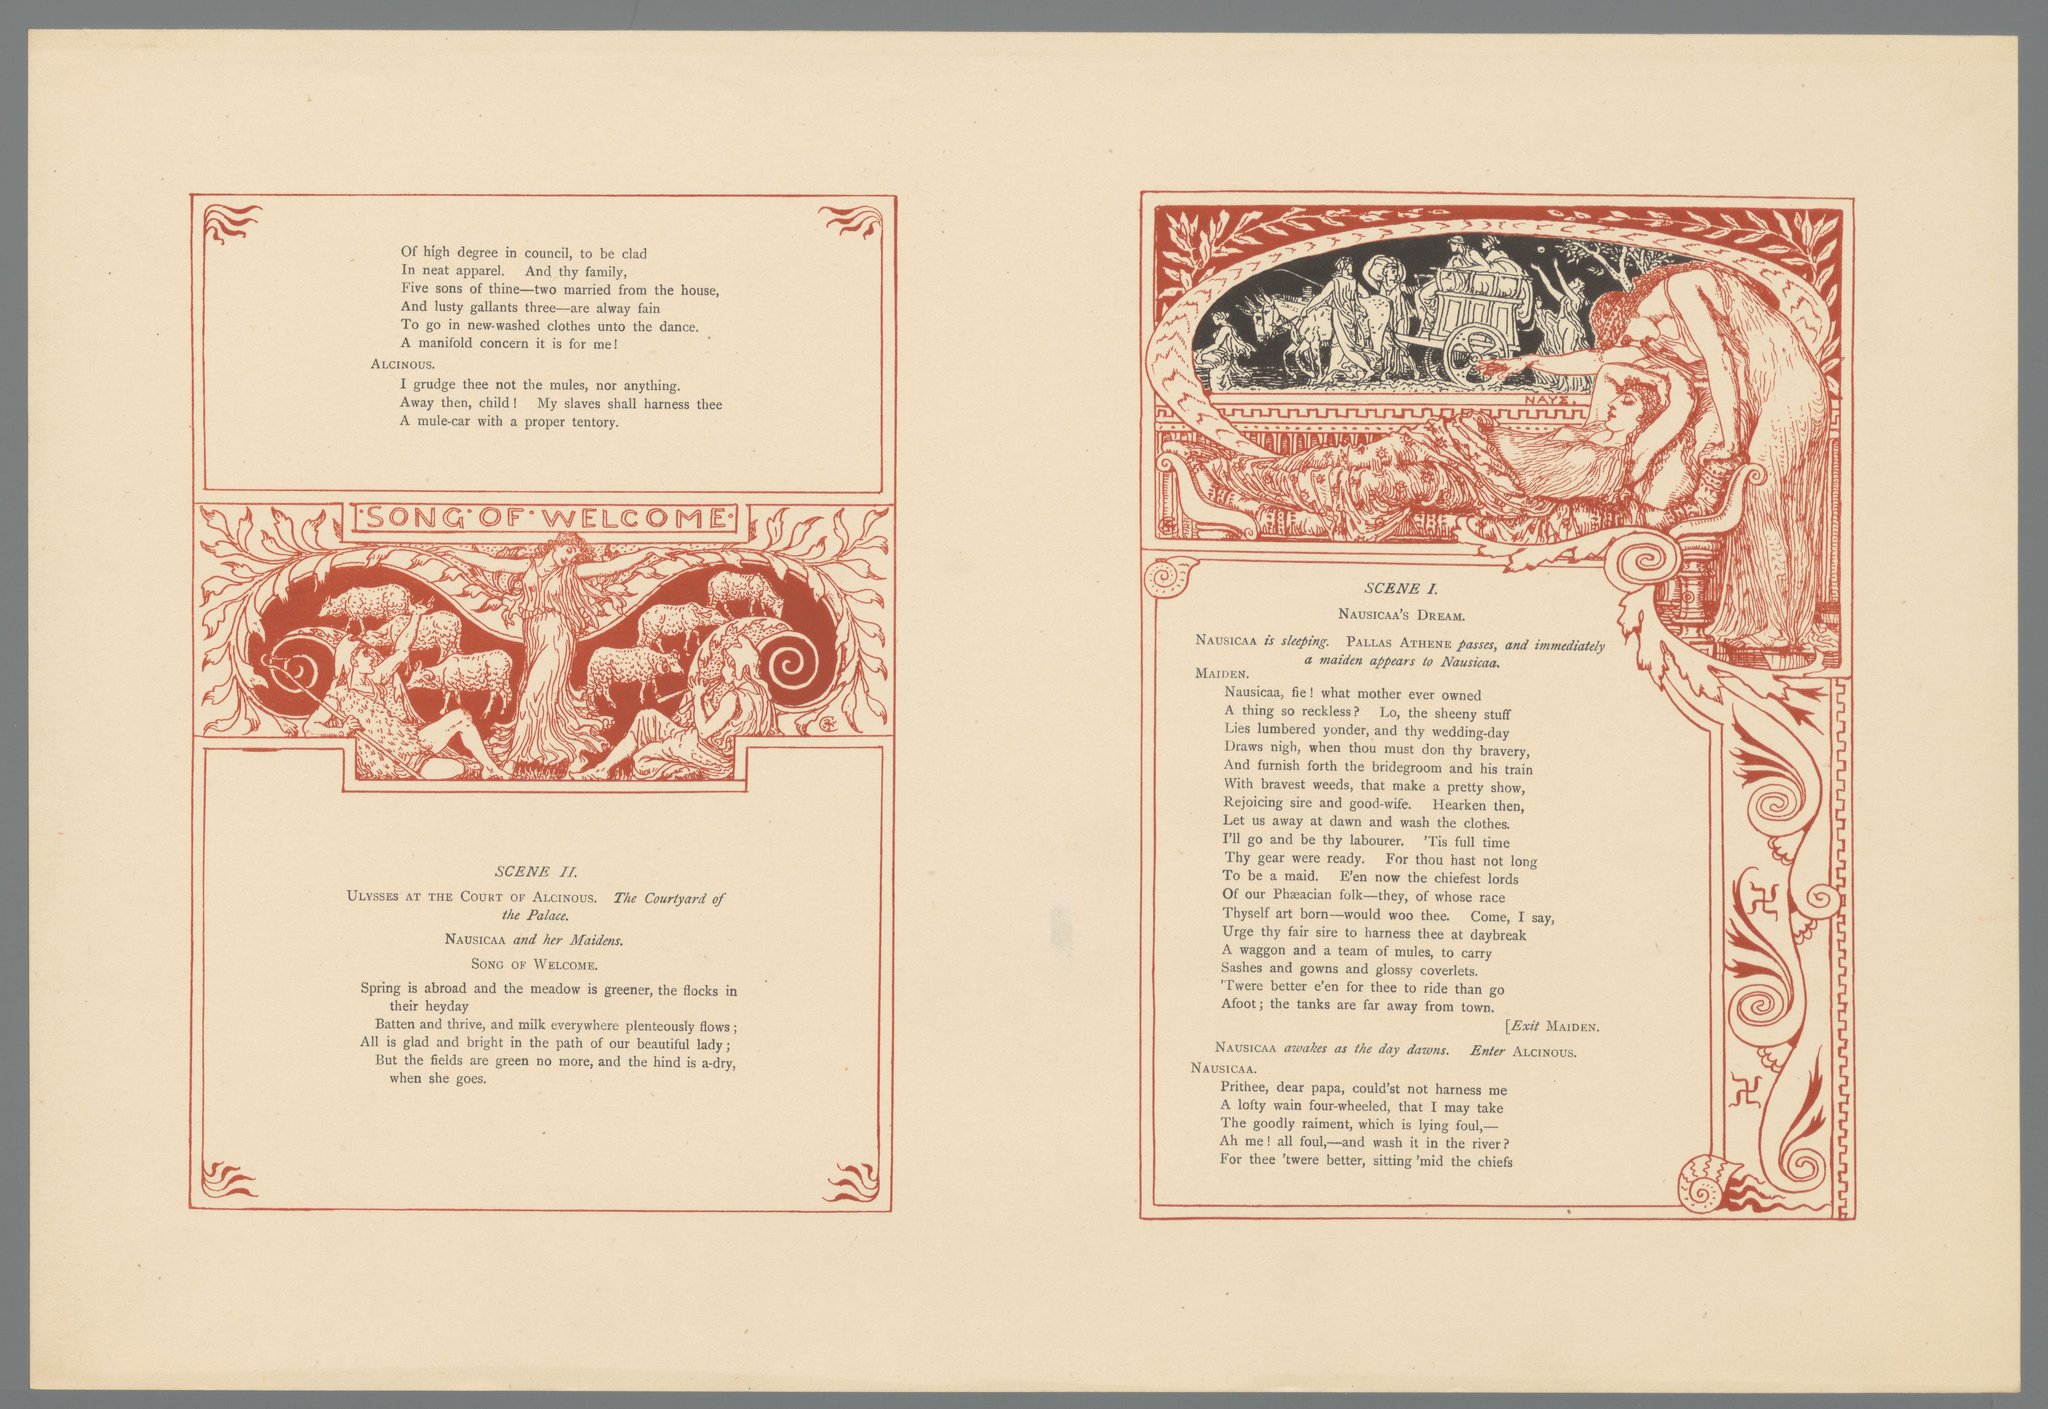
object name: book illustration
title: Voorstellingen van Nausikäa en haar droom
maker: walter crane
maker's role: draughtsman, print maker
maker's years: 1845-1915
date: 1887-1888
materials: paper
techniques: letterpress printing, lithograph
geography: london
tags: ulysses with the phaeacians (homer, odyssey vi-viii), nausicaa on her way to the sea-shore with her companions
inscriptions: collector's mark: Lugt 2228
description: Prent uit: Warr, George C. Echoes of Hellas: the tale of Troy & the story of Orestes from Homer & Aeschylus. Londen: Marcus Ward & Company, [1887/1888].